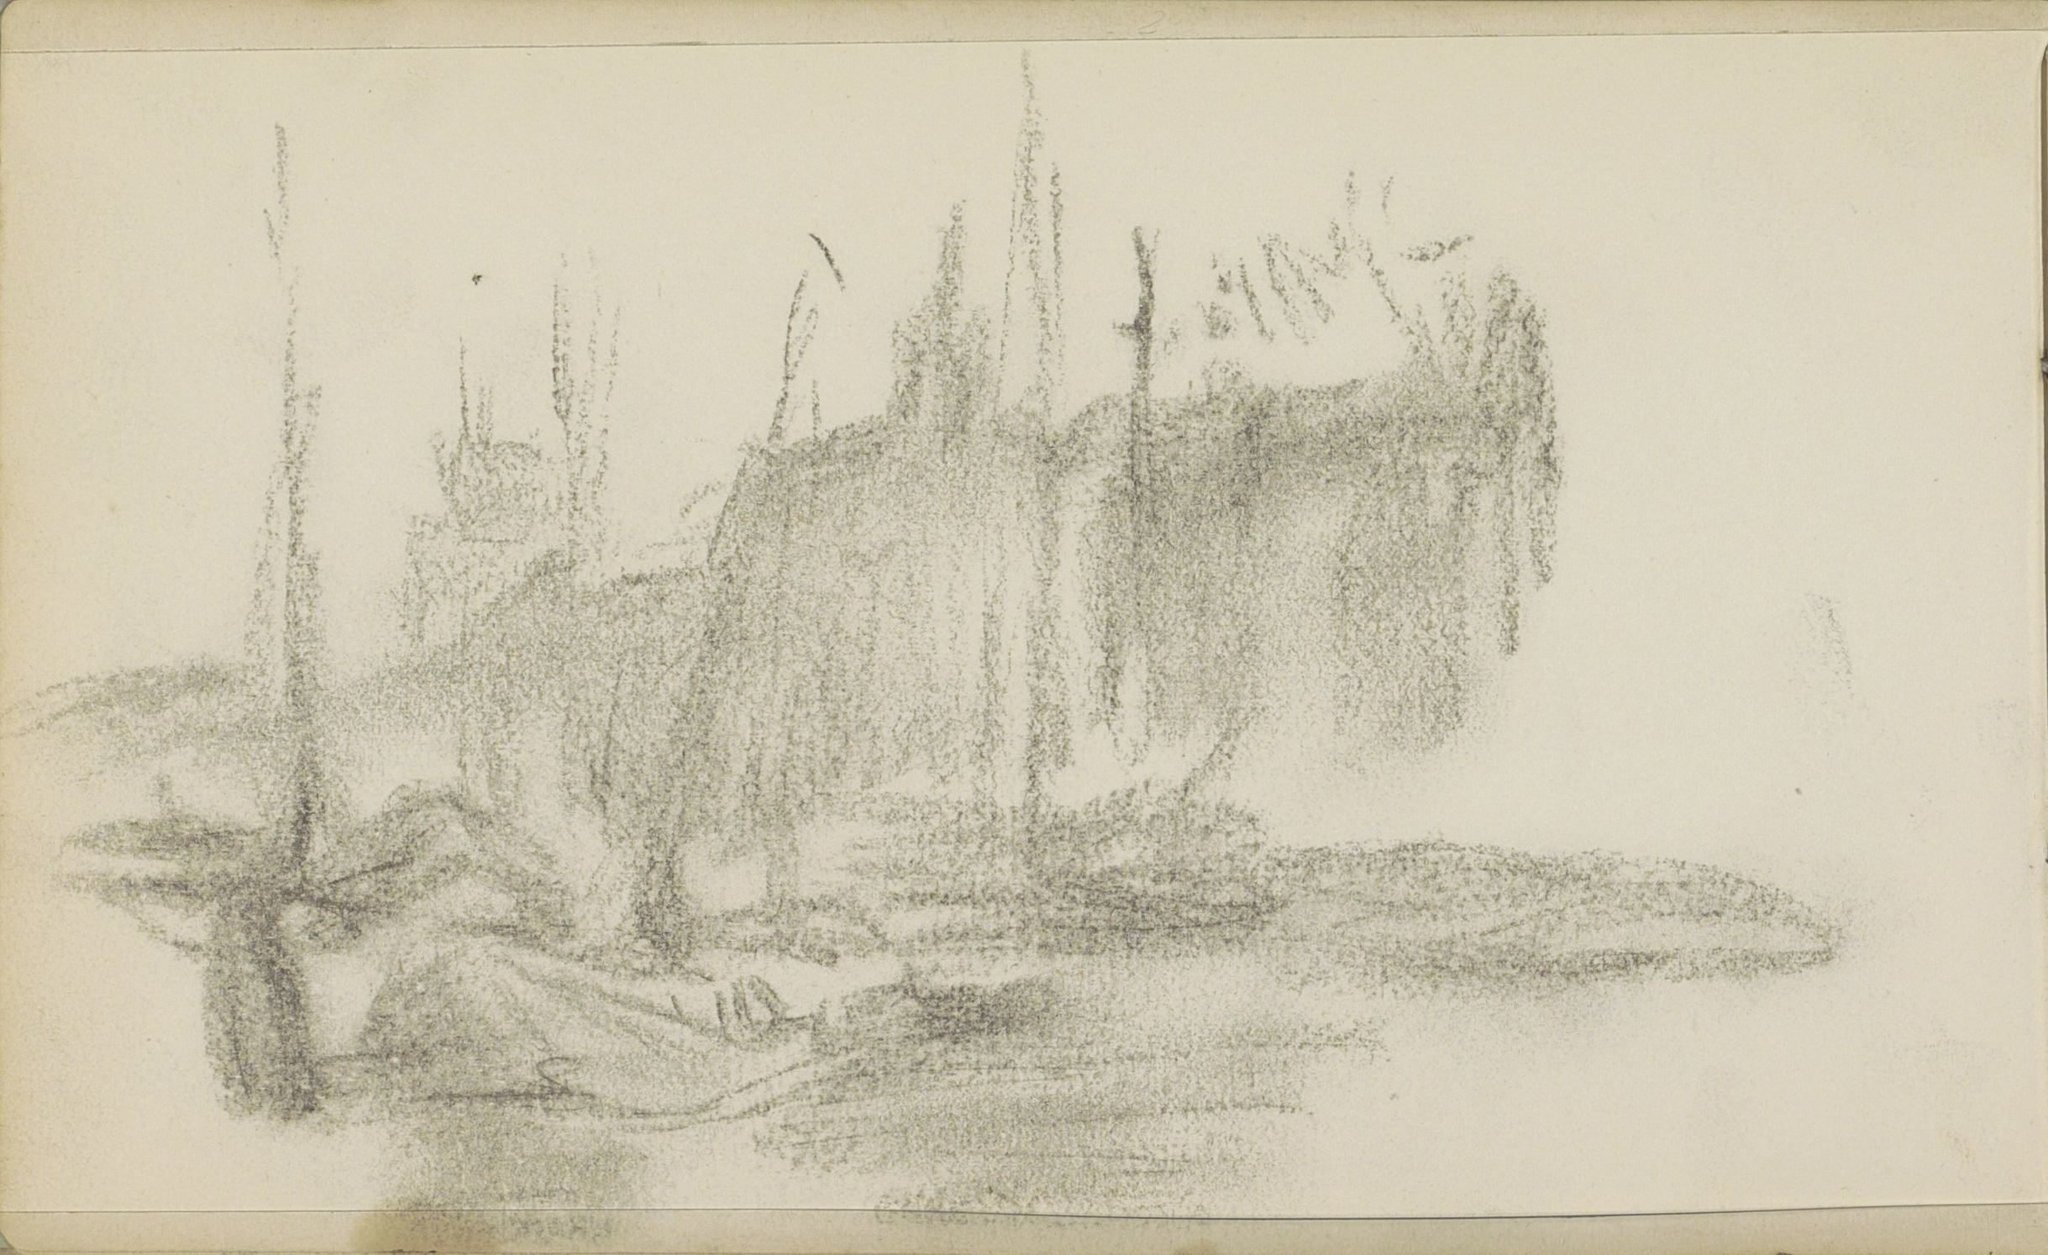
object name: sketchbook leaf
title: Havengezicht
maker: jozef israëls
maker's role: draughtsman, painter, print maker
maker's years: 1824-1911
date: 1834-1911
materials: chalk, paper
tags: harbour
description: Blad 34 verso uit een schetsboek met 42 bladen.